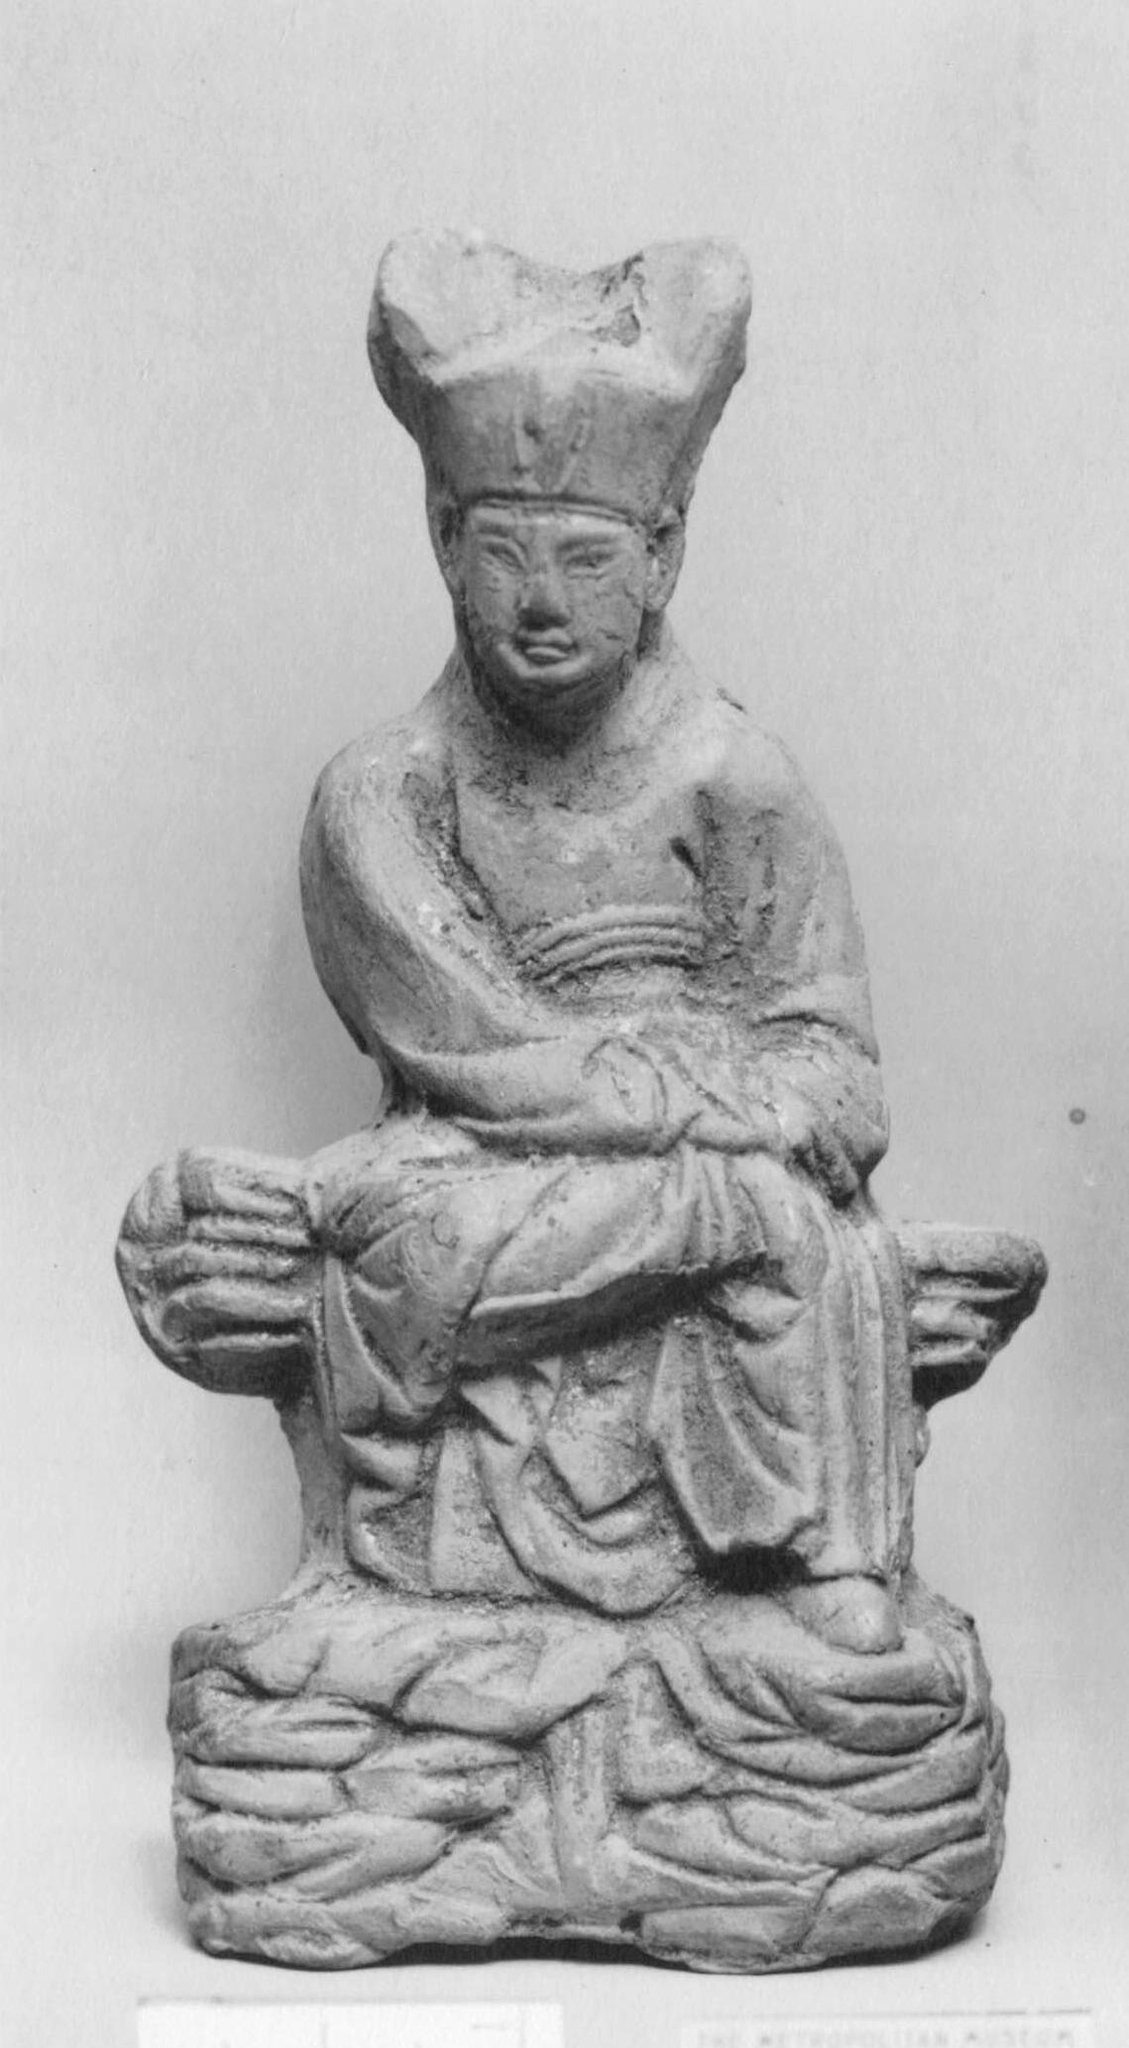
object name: figure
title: Figure of Official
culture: chinese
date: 960-1279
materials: pottery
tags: men